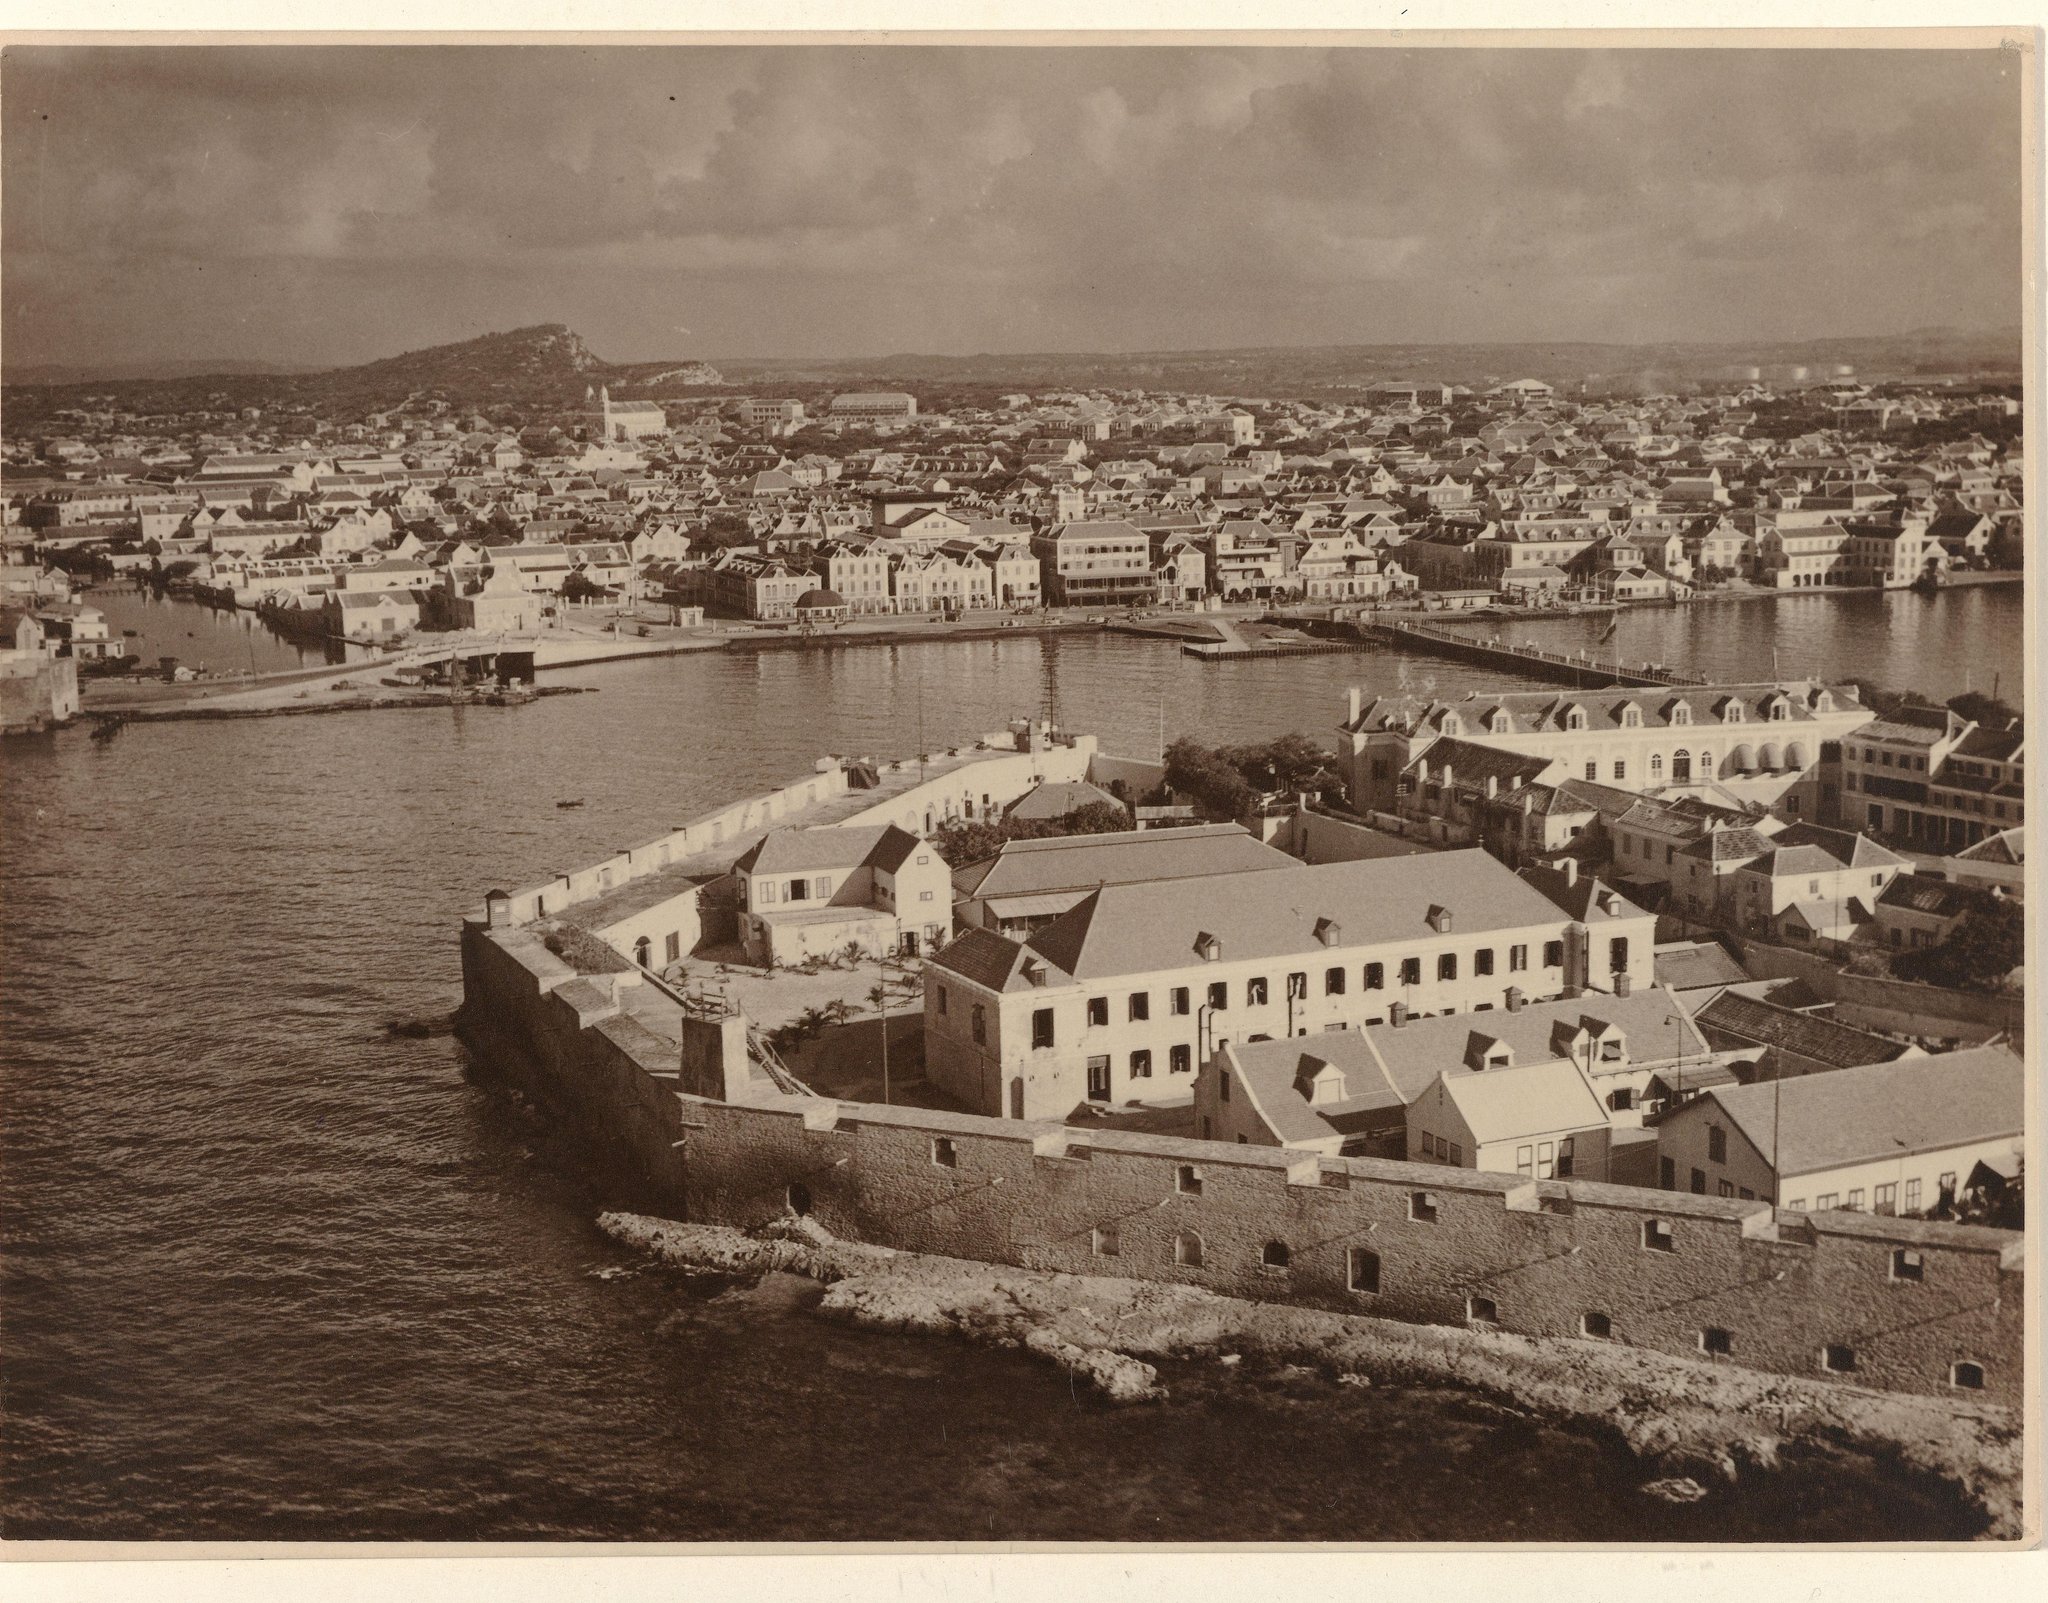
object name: photograph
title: Gezicht op het Waterfort in Willemstad, Curaçao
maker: fischer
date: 1937-1940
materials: photographic support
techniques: photography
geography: willemstad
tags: willemstad, curaçao